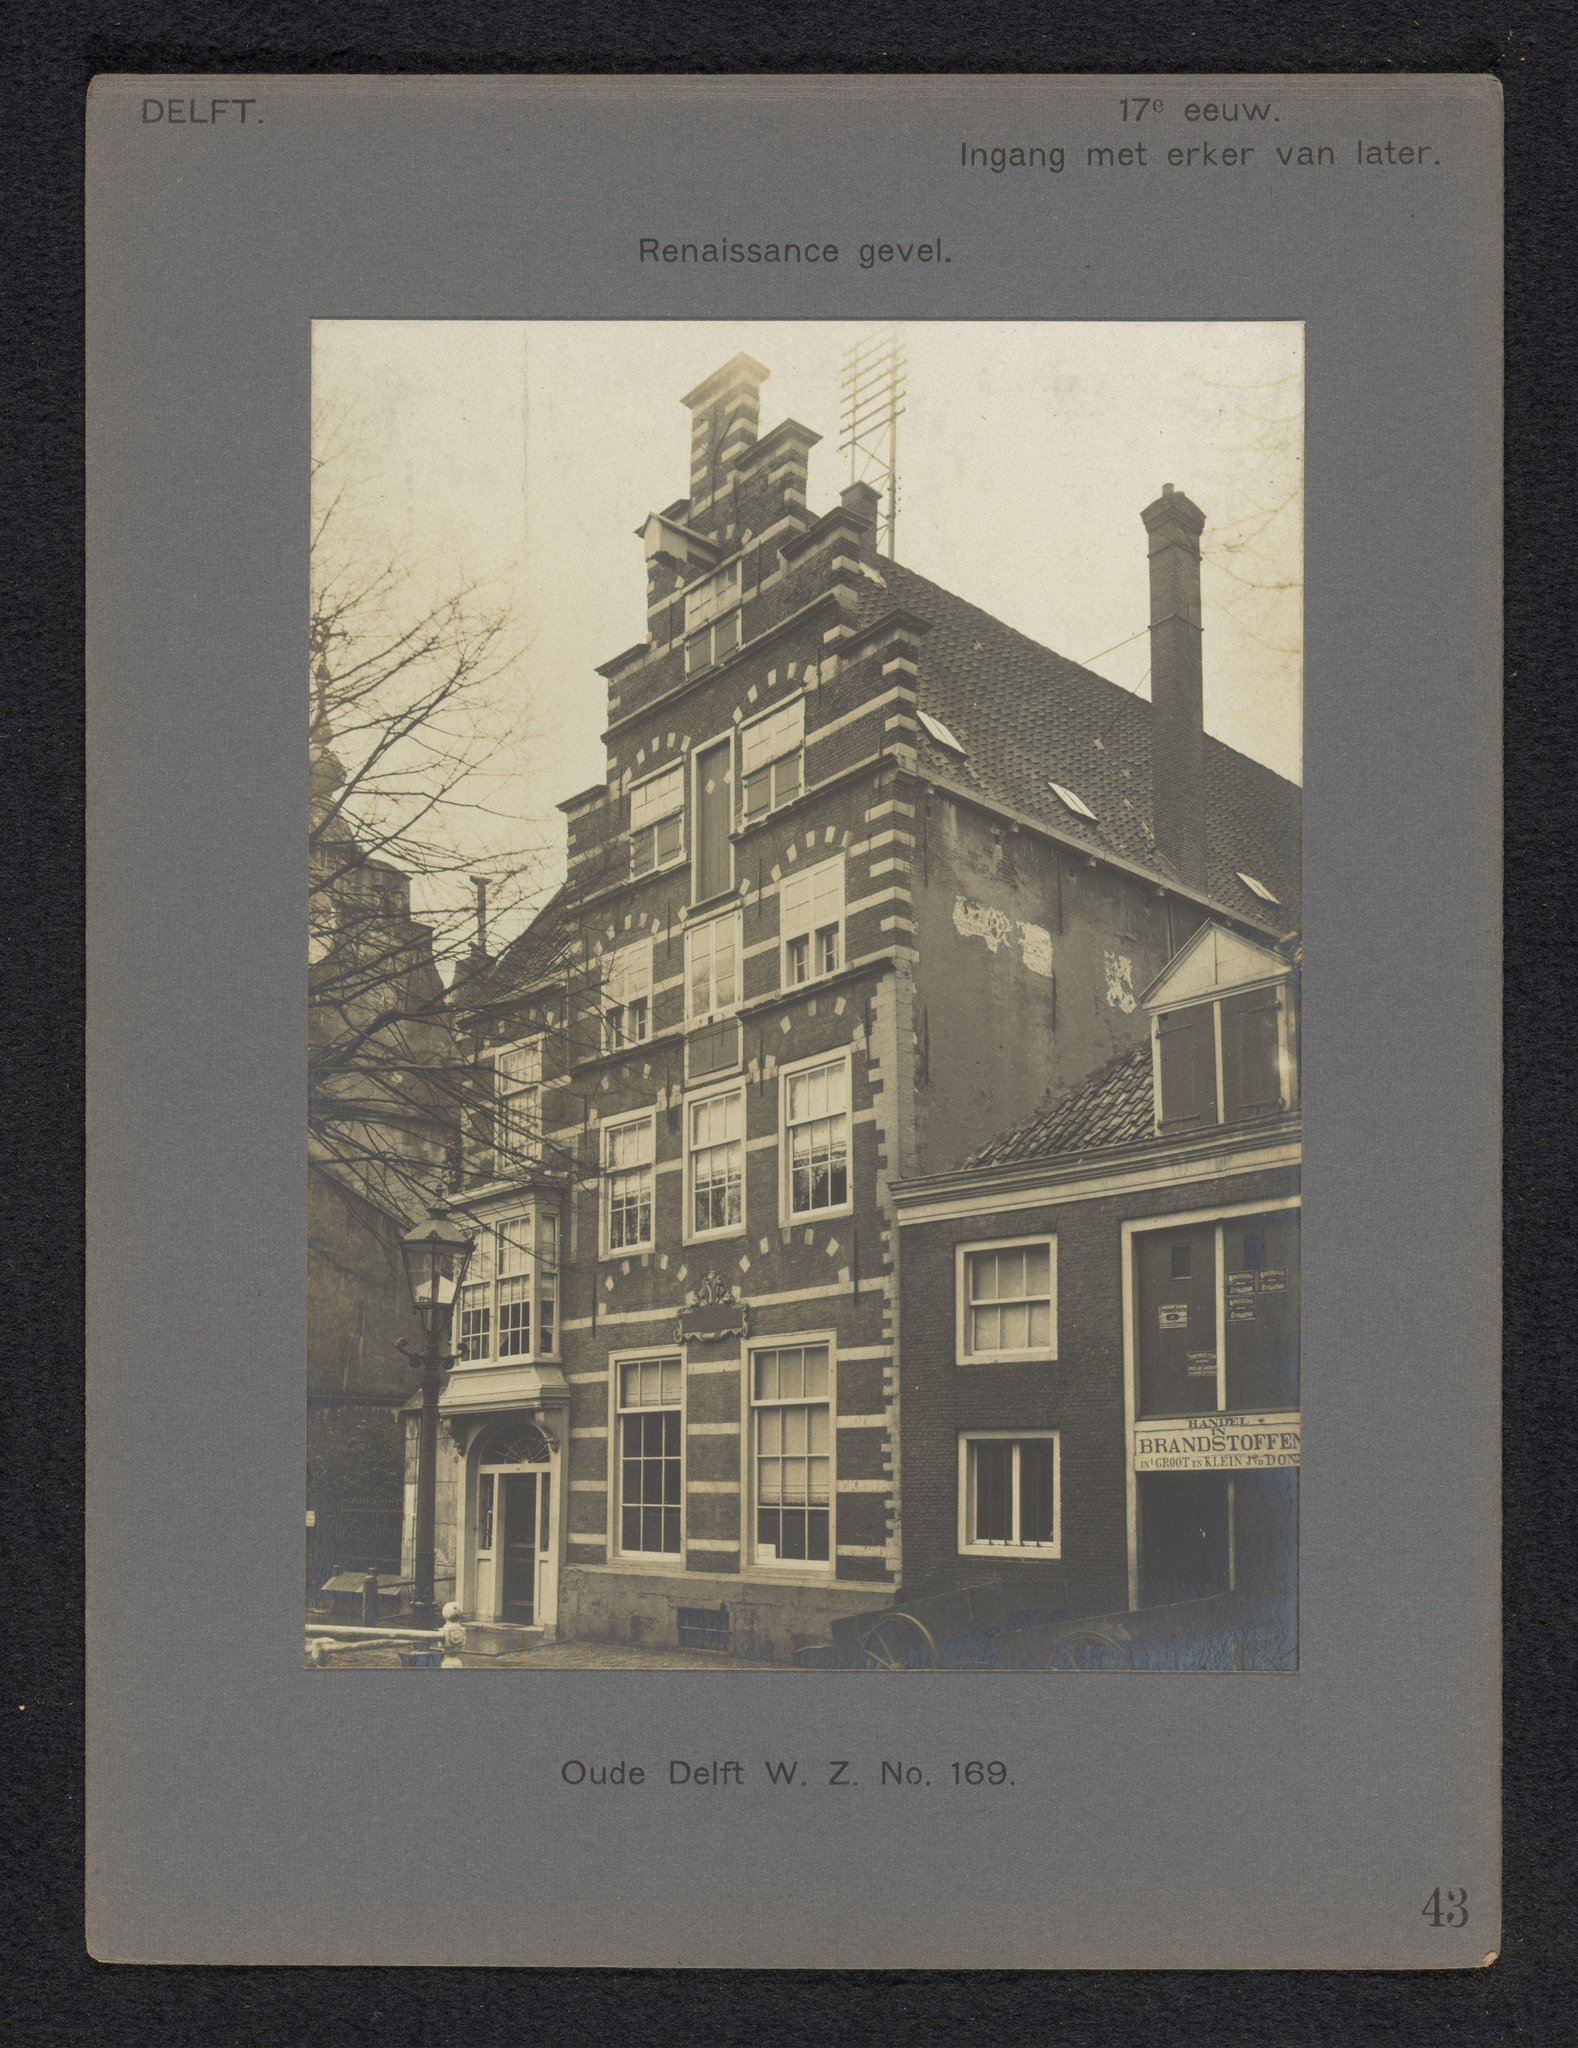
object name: photograph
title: Oude Delft W.Z. No. 169. Renaissance gevel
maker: Anonymous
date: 1900-1904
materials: cardboard, photographic support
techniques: gelatin silver print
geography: delft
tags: urban housing, decorated gable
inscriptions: inscription: ‘Het recht van reproductie dezer photo's wordt door den Uitgever voorbehouden.’, inscription: ‘Delft. 17e eeuw. Ingang met erker van later.’, number: ‘43’